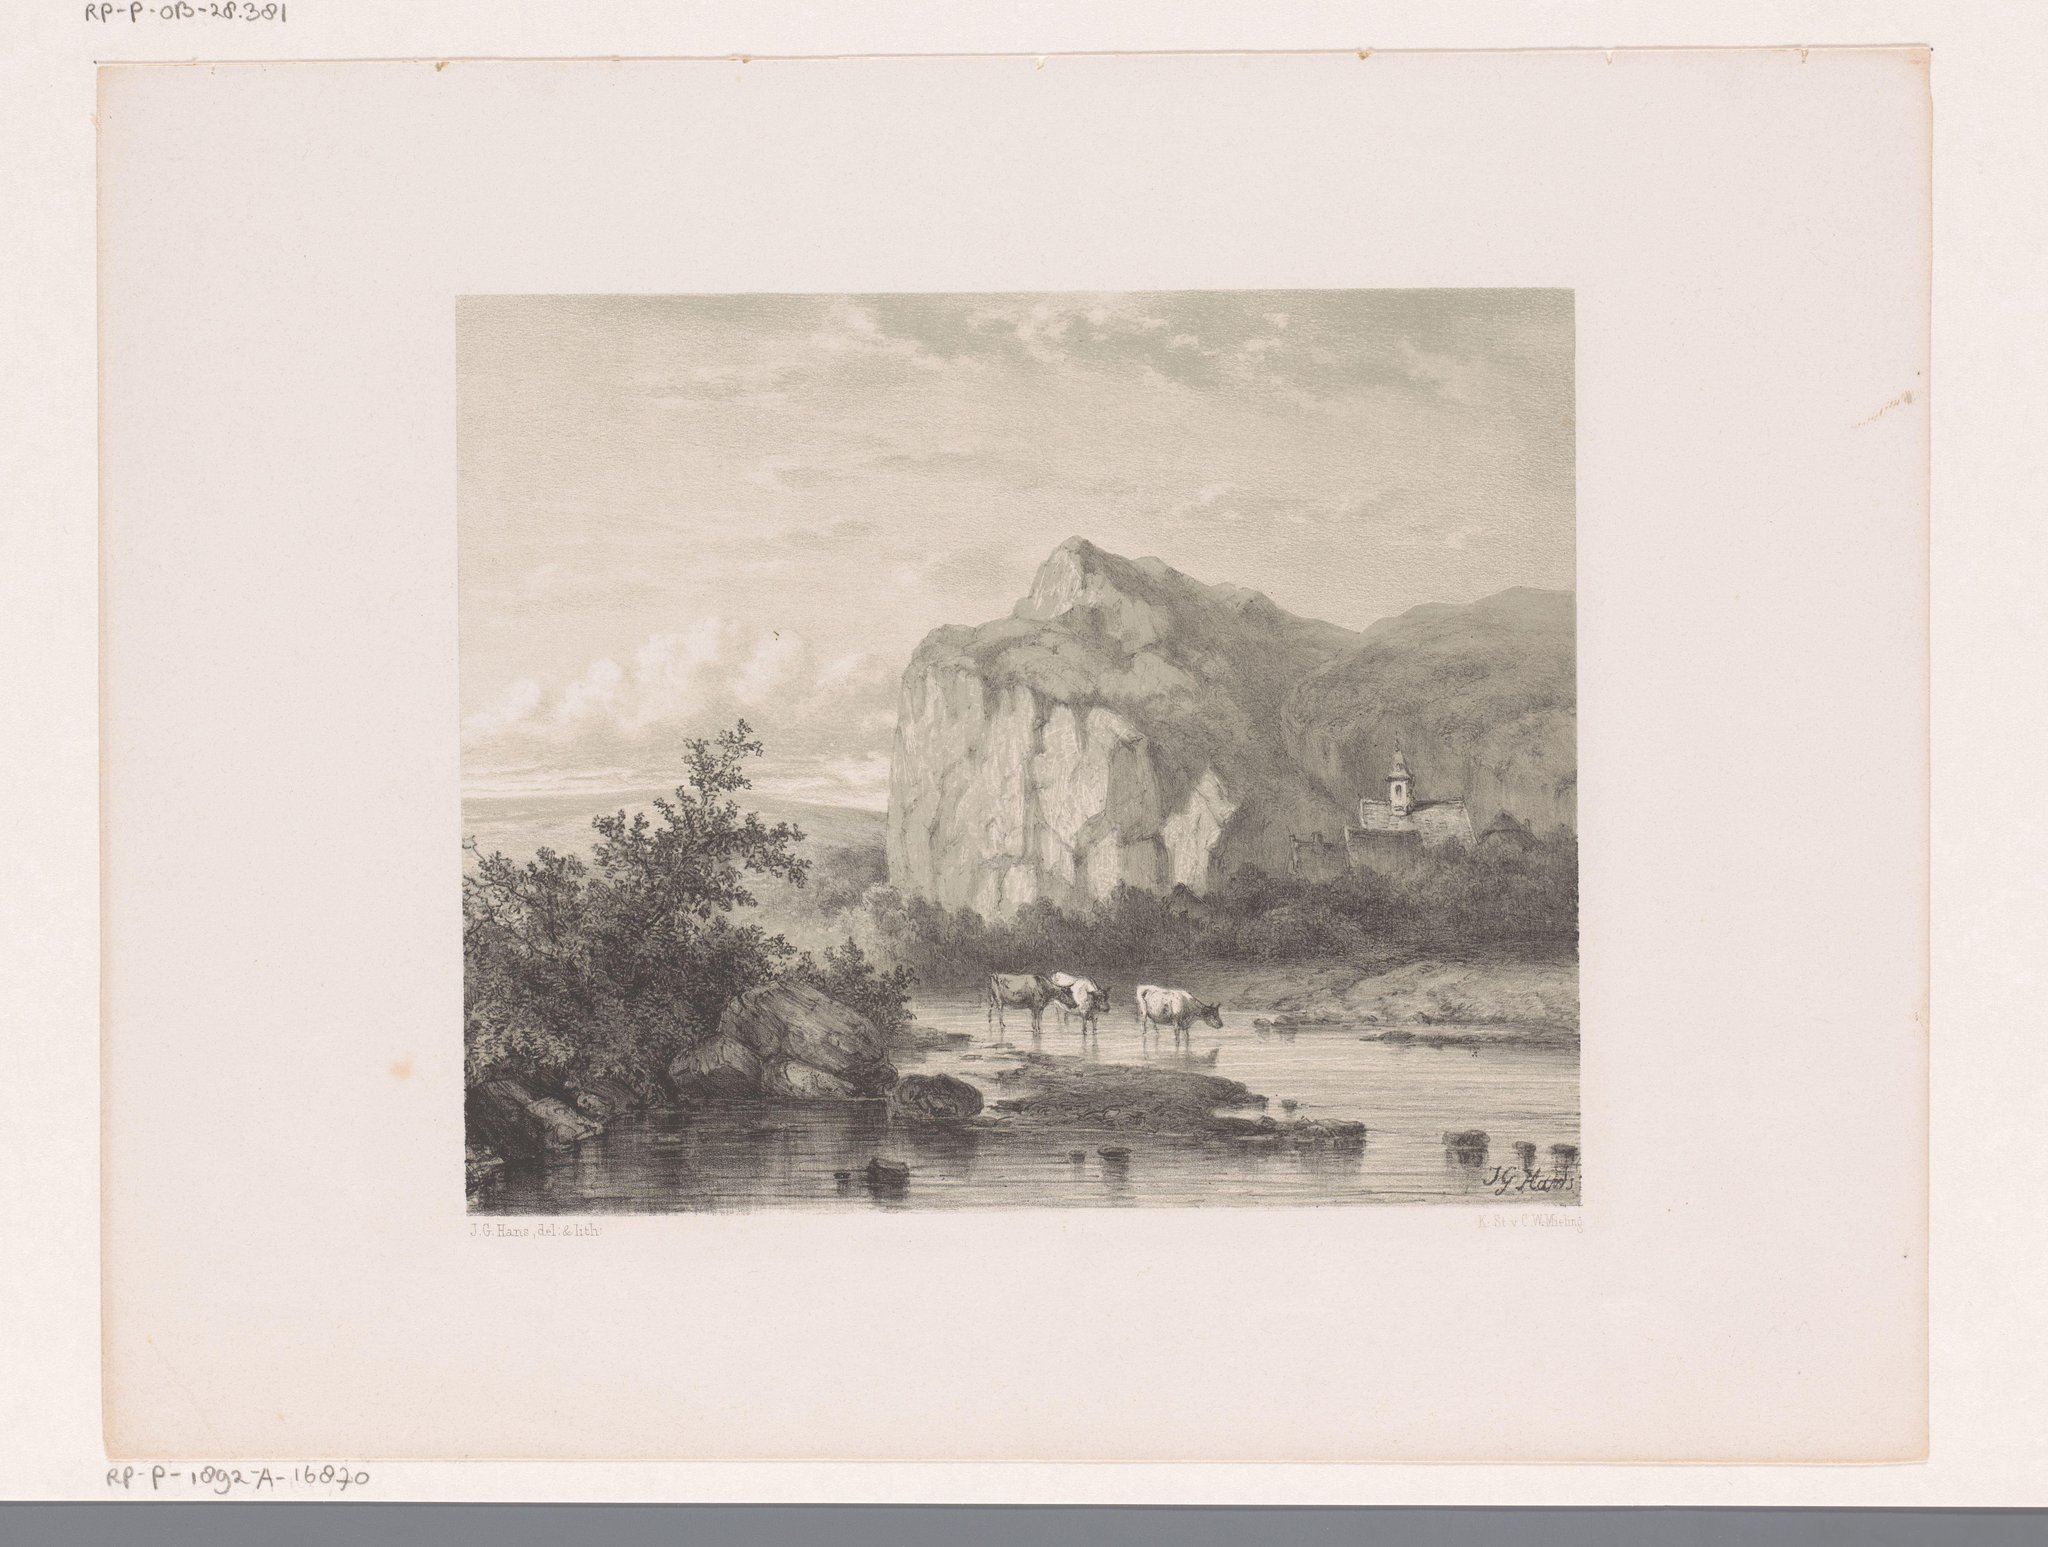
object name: print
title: Bergachtig landschap met drie koeien in het water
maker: josefus gerardus hans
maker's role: painter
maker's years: 1826-1891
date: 1847-1863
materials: paper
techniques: tone lithography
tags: cow, mountains (+ landscape with figures, staffage)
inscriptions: collector's mark: Lugt 2228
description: Rechts verscholen achter bomen enkele huizen en een kerk.